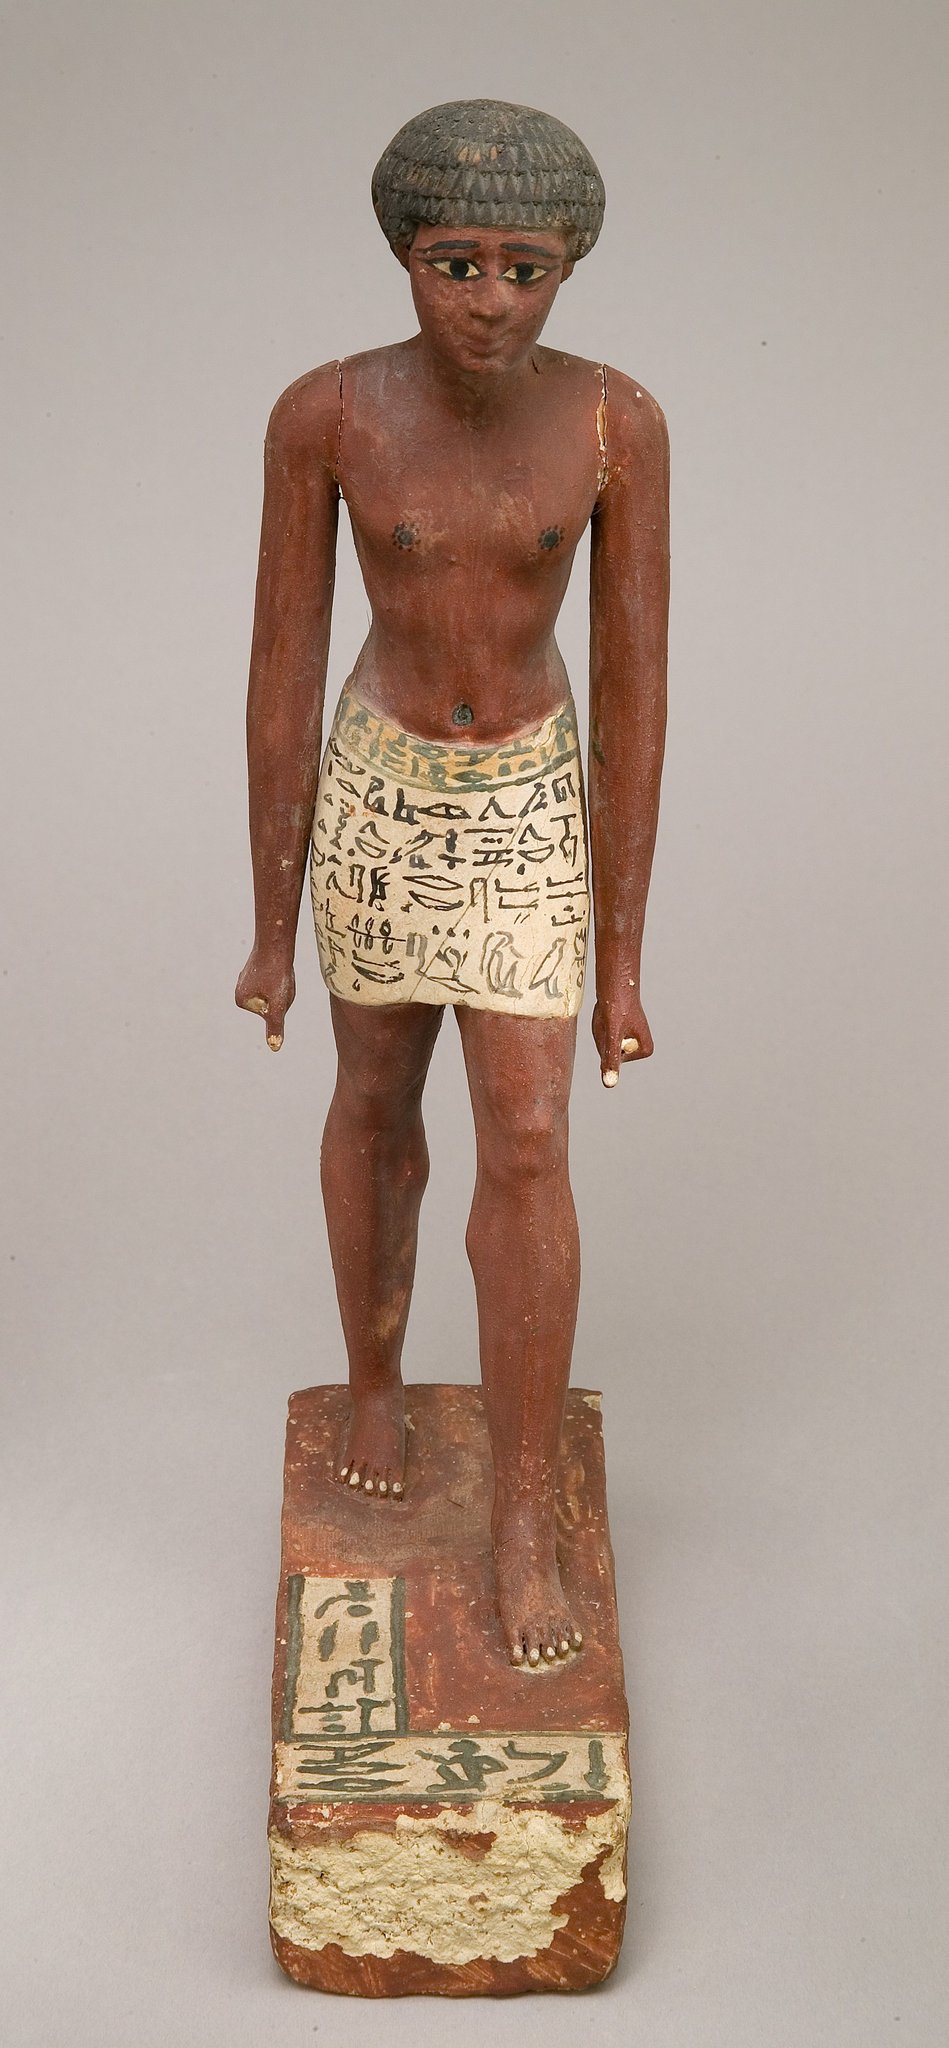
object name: statuette, merer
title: Statuette of Merer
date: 1981-1802 BCE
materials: gesso, paint, wood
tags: men,hieroglyphs